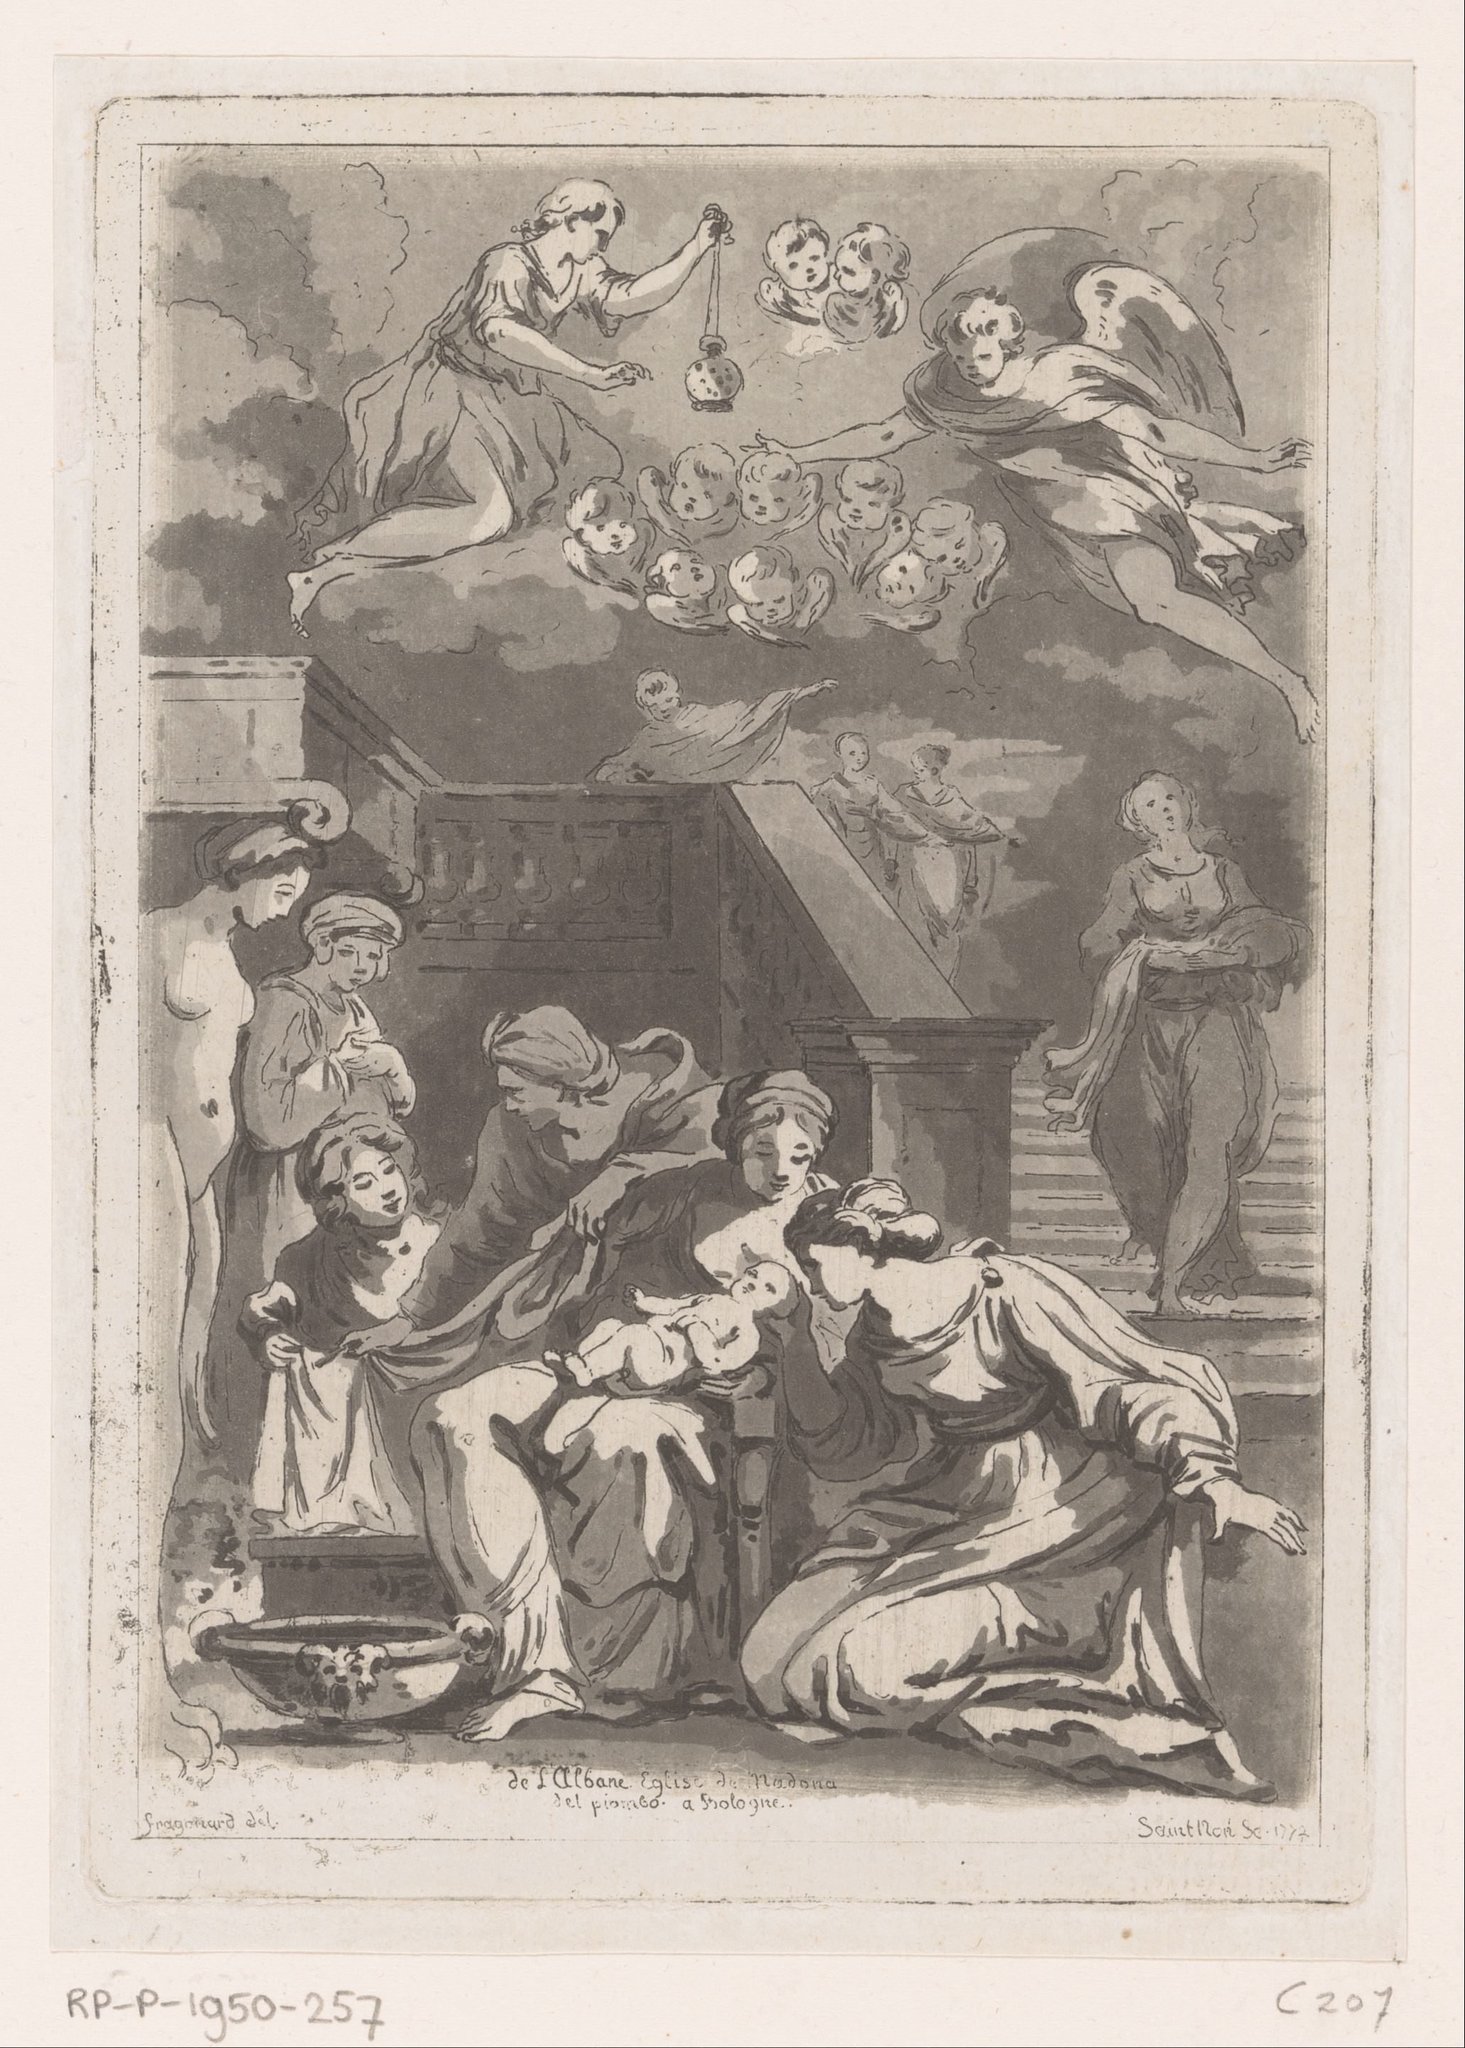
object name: print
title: Fragmenten gekozen uit schilderingen en schilderijen in Italië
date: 1772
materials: paper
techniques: aquatint, etching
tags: cherubs, i.e. children's heads with wings, circumcision of the christ-child by the priest in the temple (luke 2:21), angels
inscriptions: date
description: Prent maakt deel uit van een serie met daarbinnen delen over specifiek Rome, Bologna, Napels en Venetië.